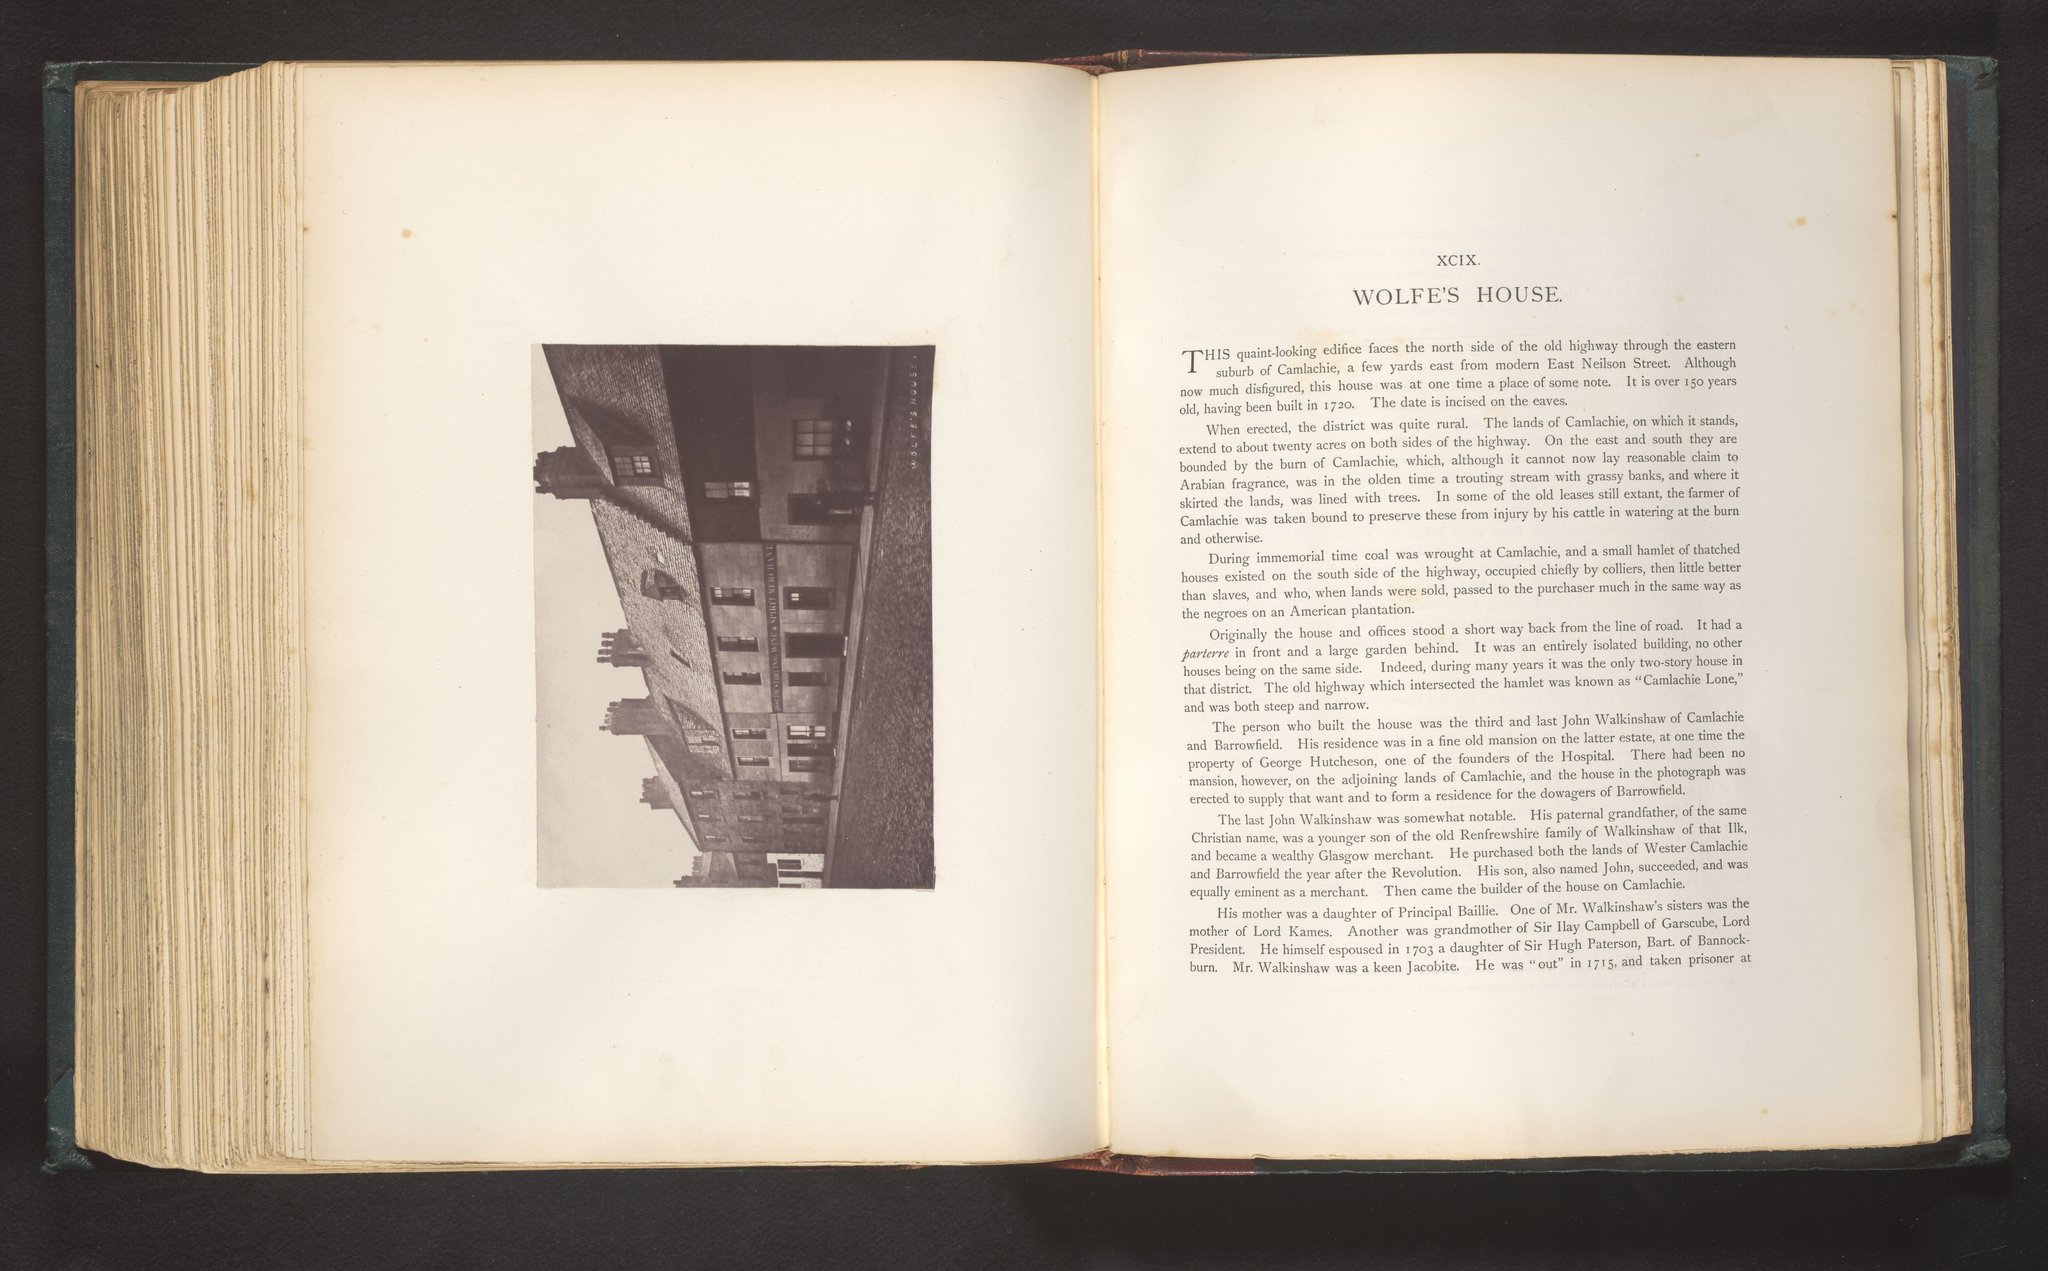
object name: page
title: Wolfe's House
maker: thomas annan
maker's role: fotograaf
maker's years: 1829-1887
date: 1868-1878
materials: paper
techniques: carbon print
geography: glasgow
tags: rural housing, e.g. country-house, villa, cottage, façade (of house or building)